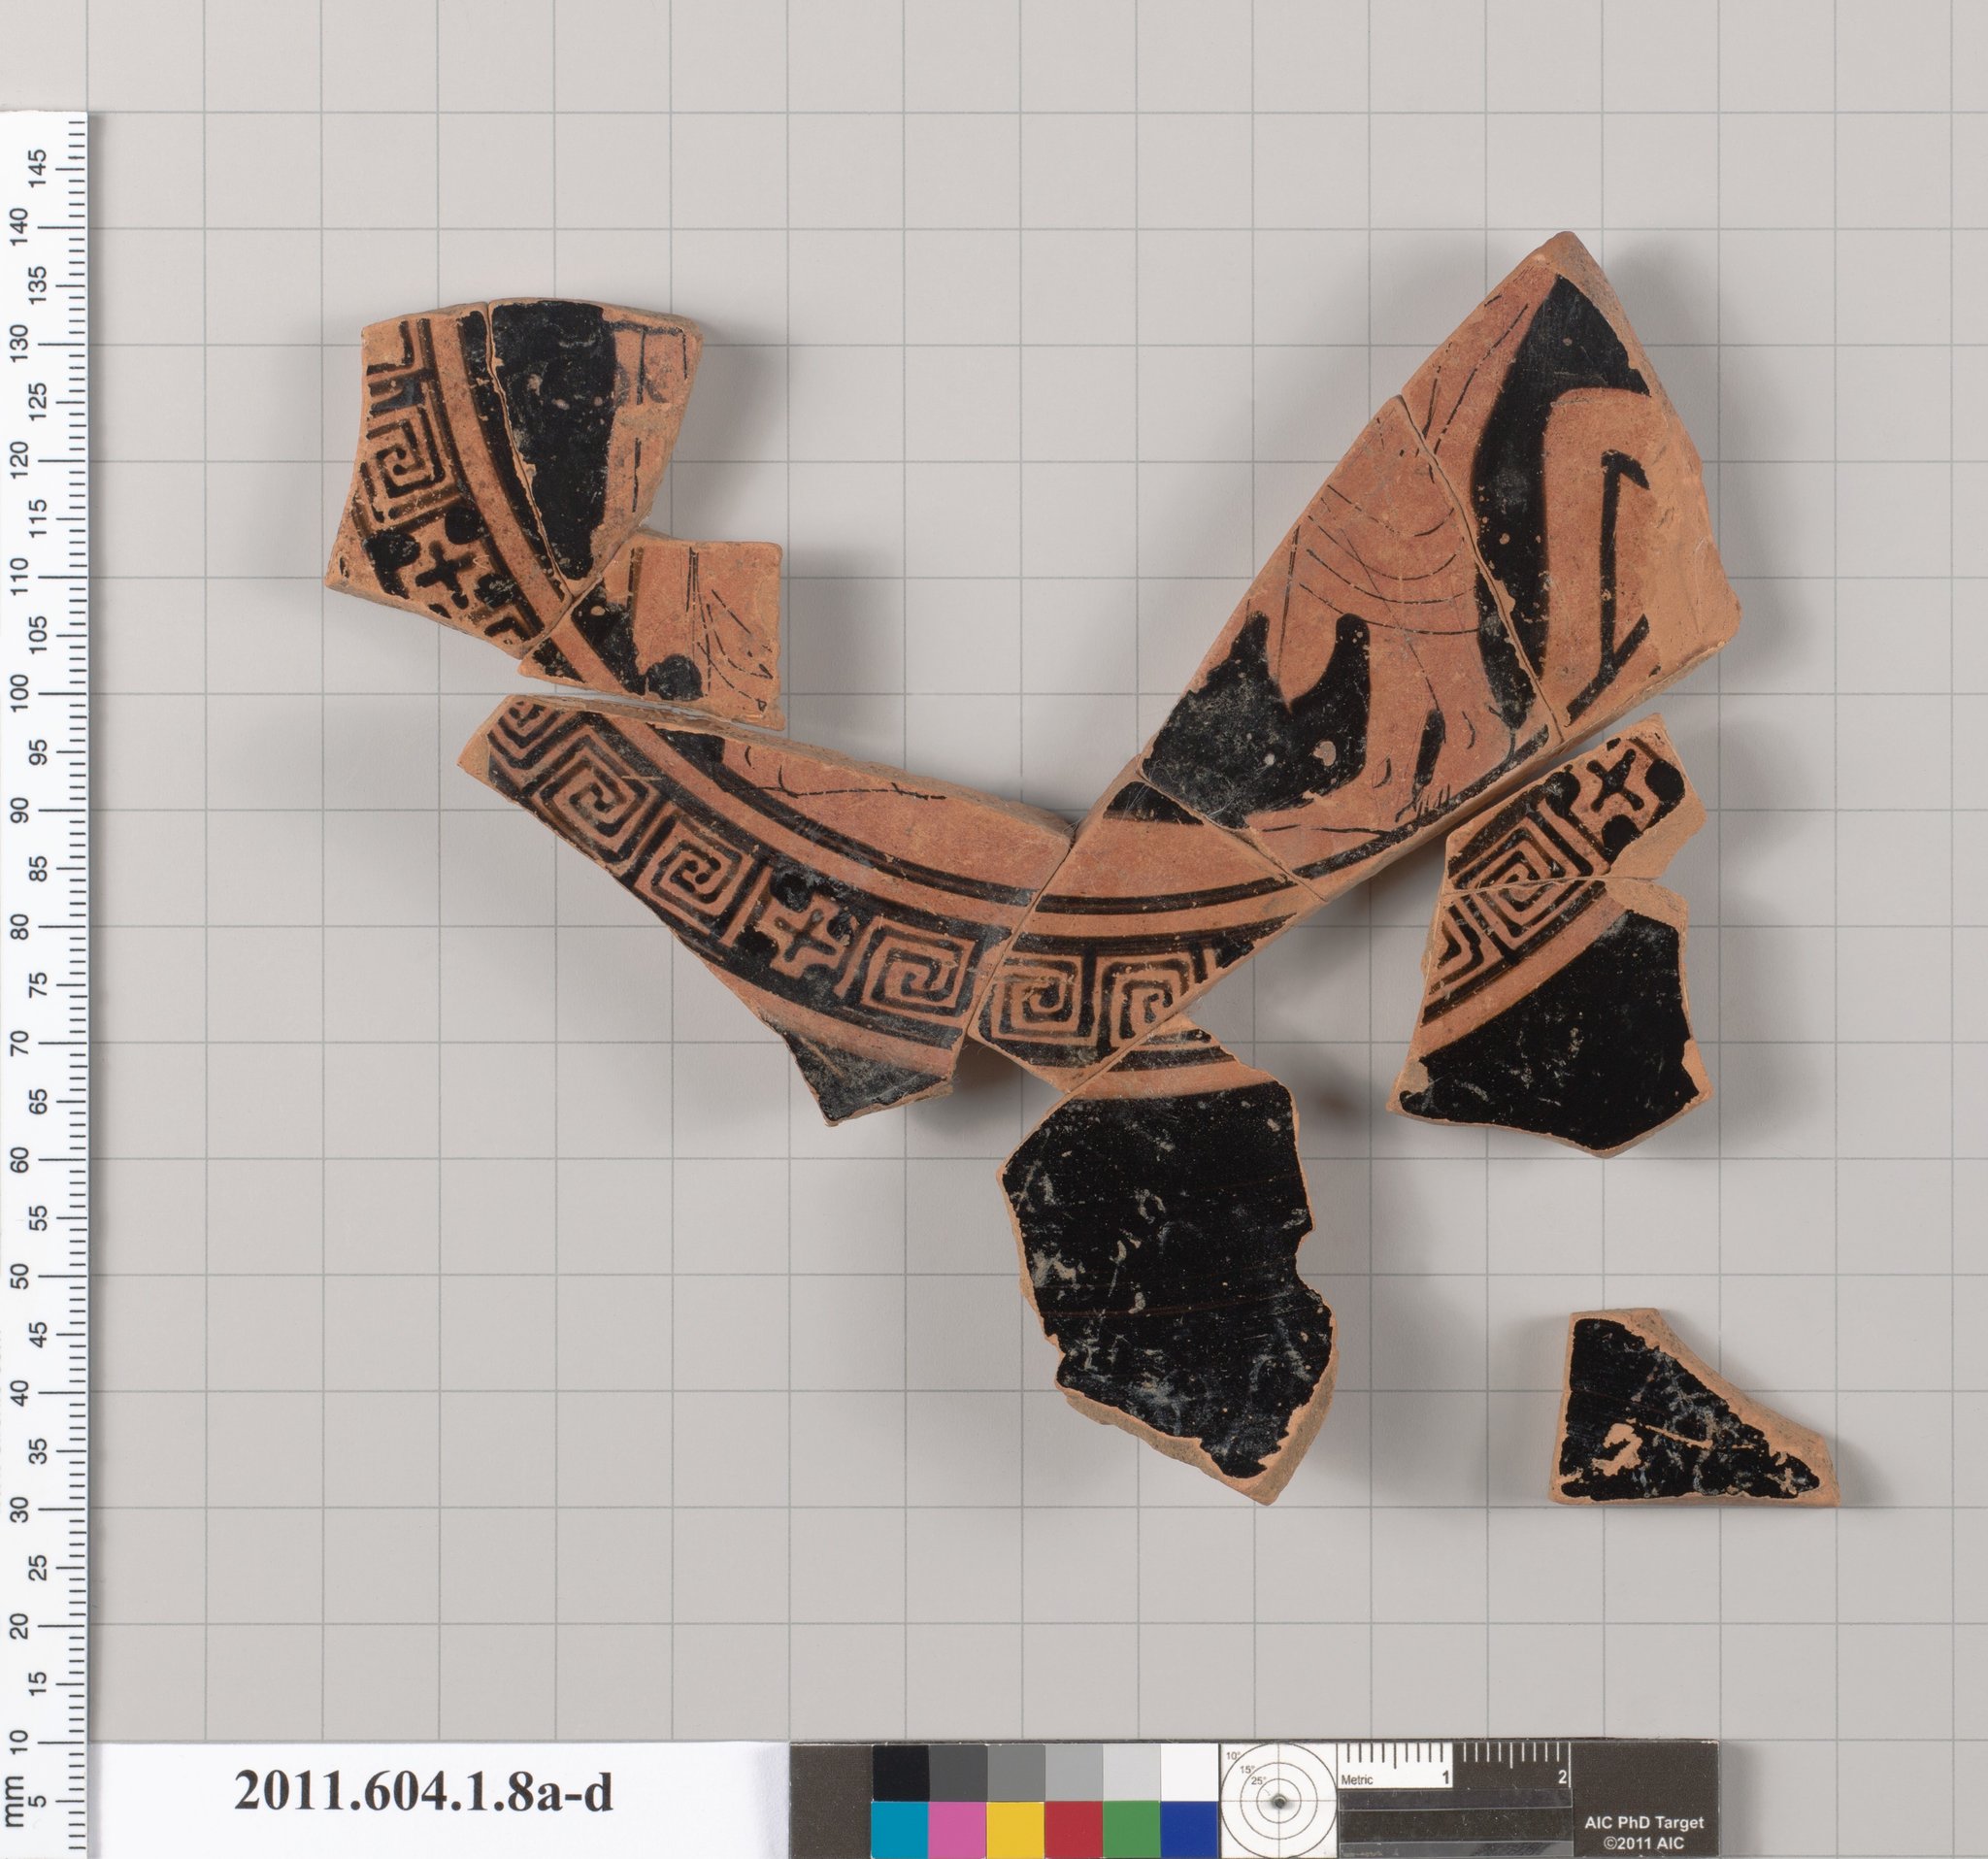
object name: kylix fragment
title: Terracotta fragments of a kylix (drinking cup)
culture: greek, attic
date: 467-435 BCE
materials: terracotta